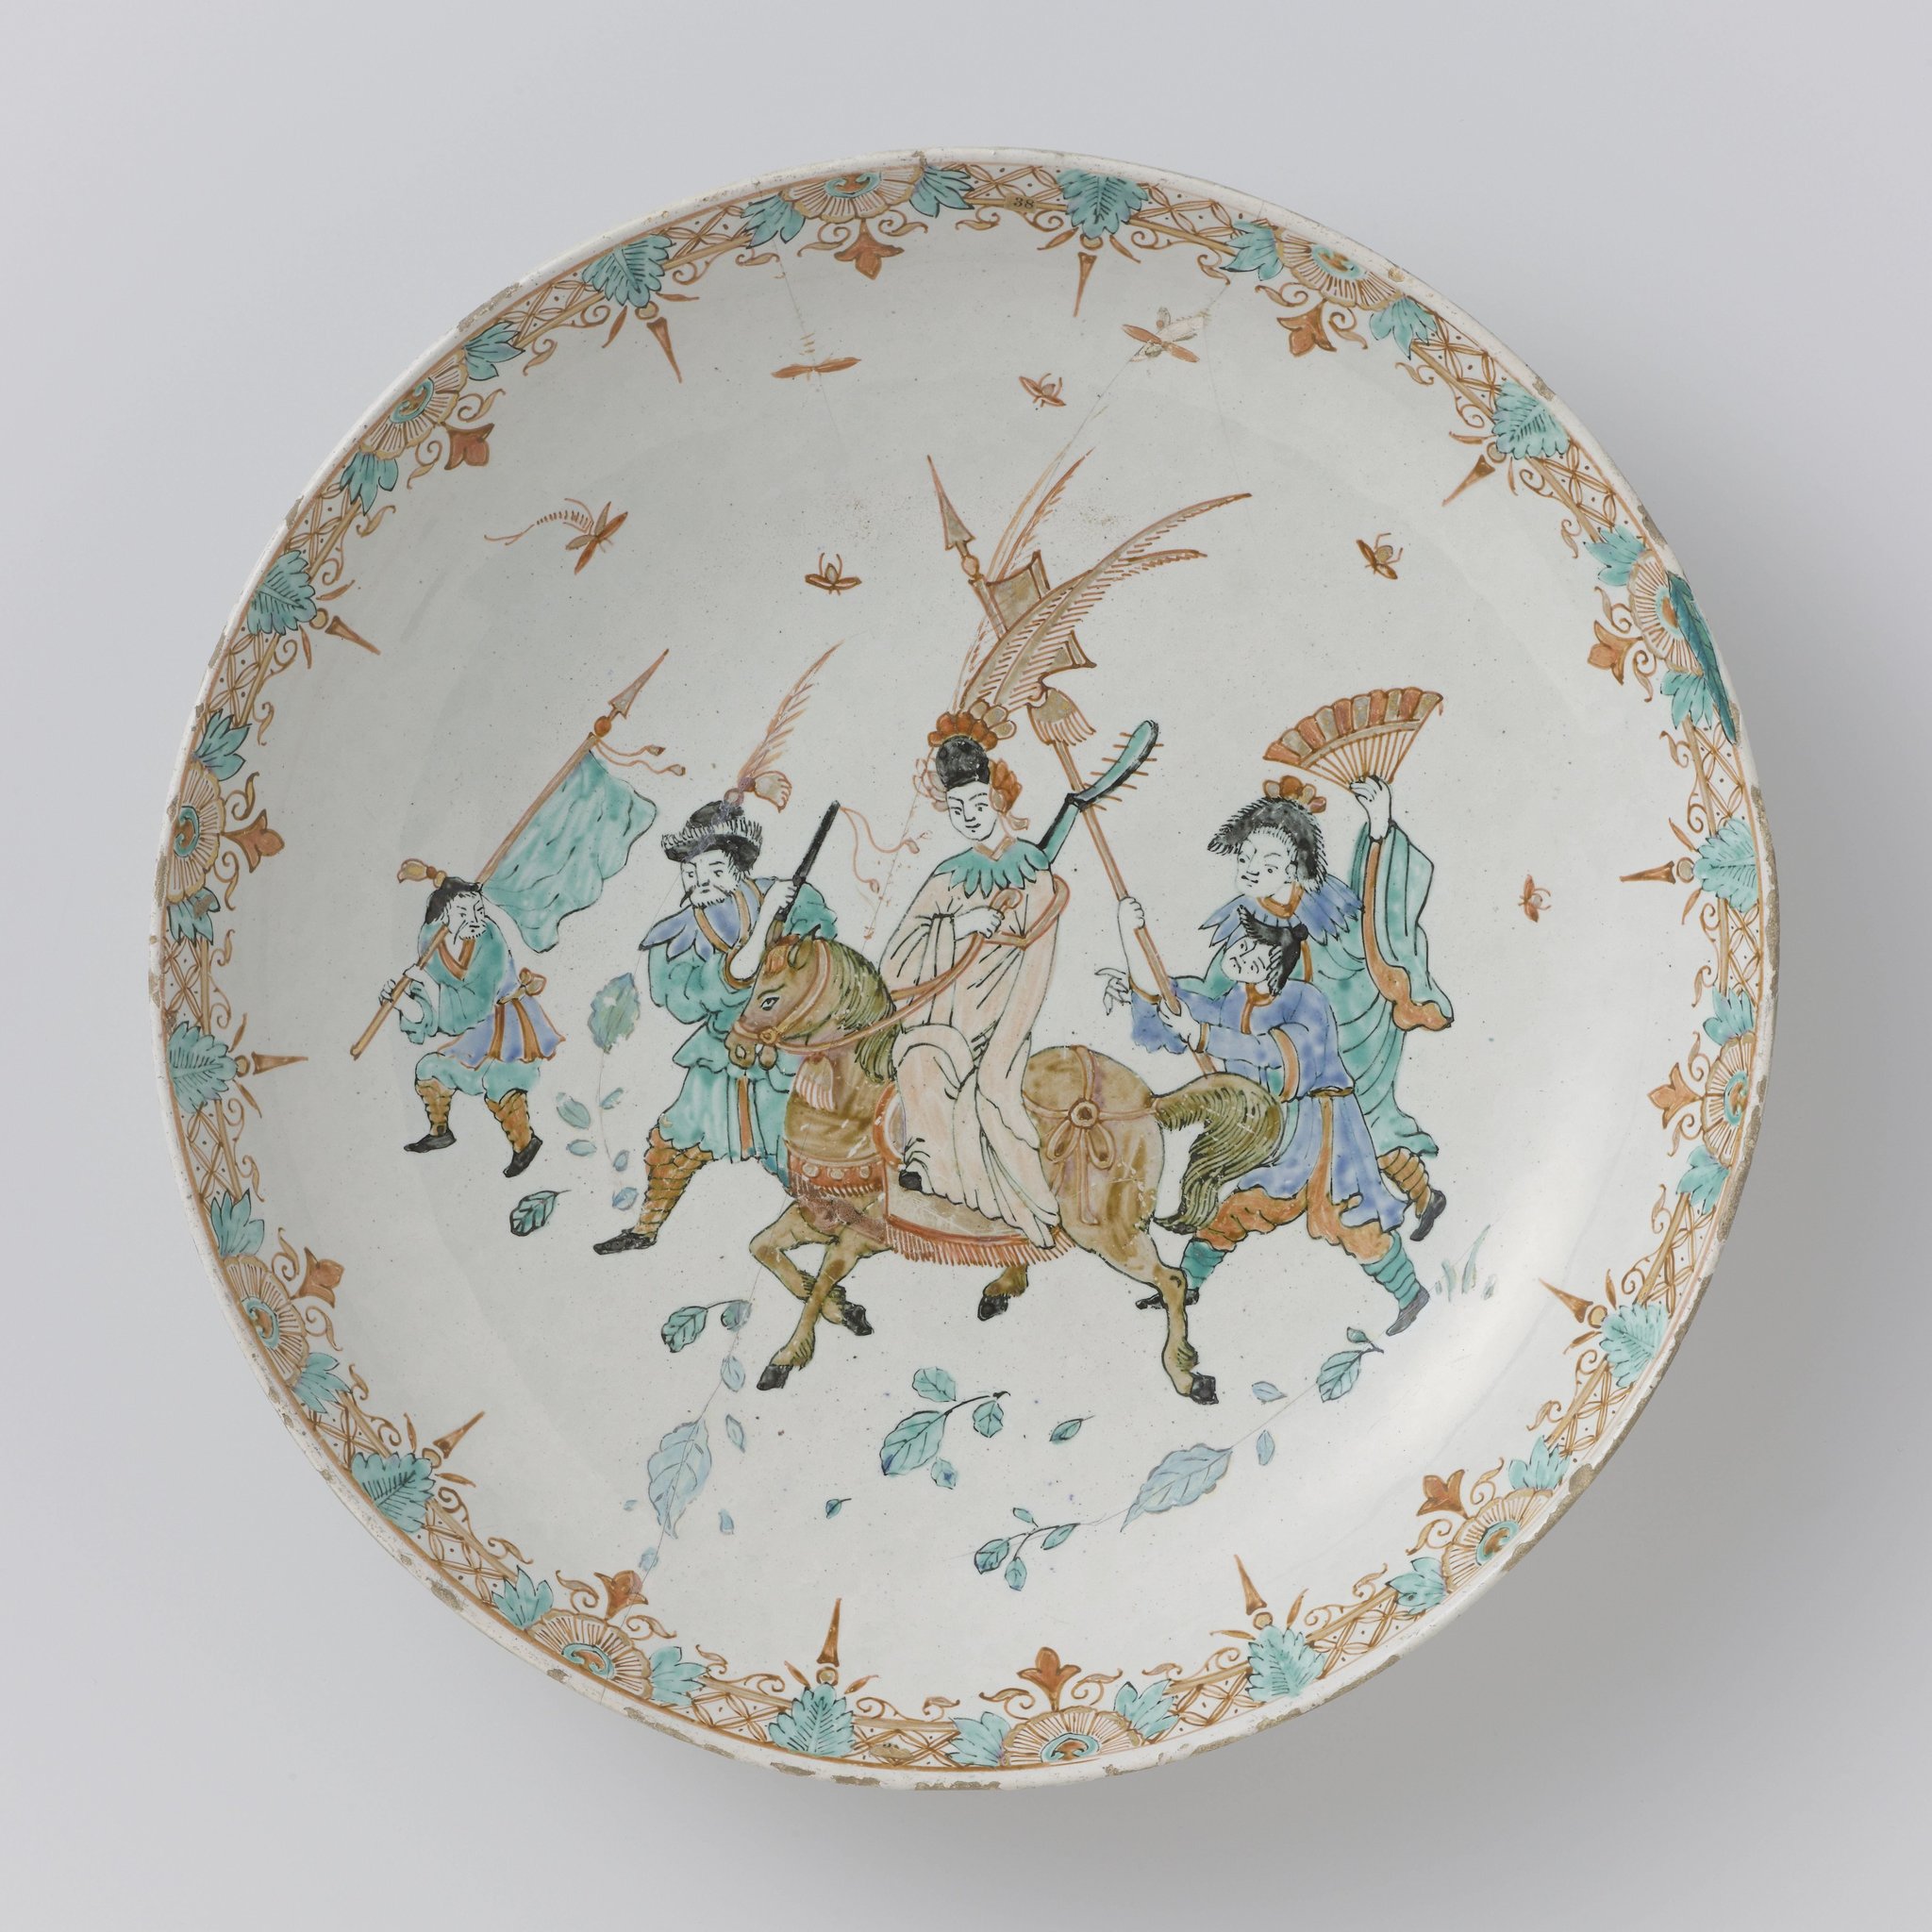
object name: platter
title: Schotel, beschilderd met Oosterse figuren, waaronder een prinses te paard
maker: adriaan van rijsselbergh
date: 1720-1730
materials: earthenware, glaze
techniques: kiln, painted, polychromy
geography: delft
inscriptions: mark: ‘AR (ineen)’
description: Two dishes. Faience. Delft, c. 1710 - 1730. The decoration attributed to Ary Rysselbergh. Given by the heirs of John F. Loudon, 1916.